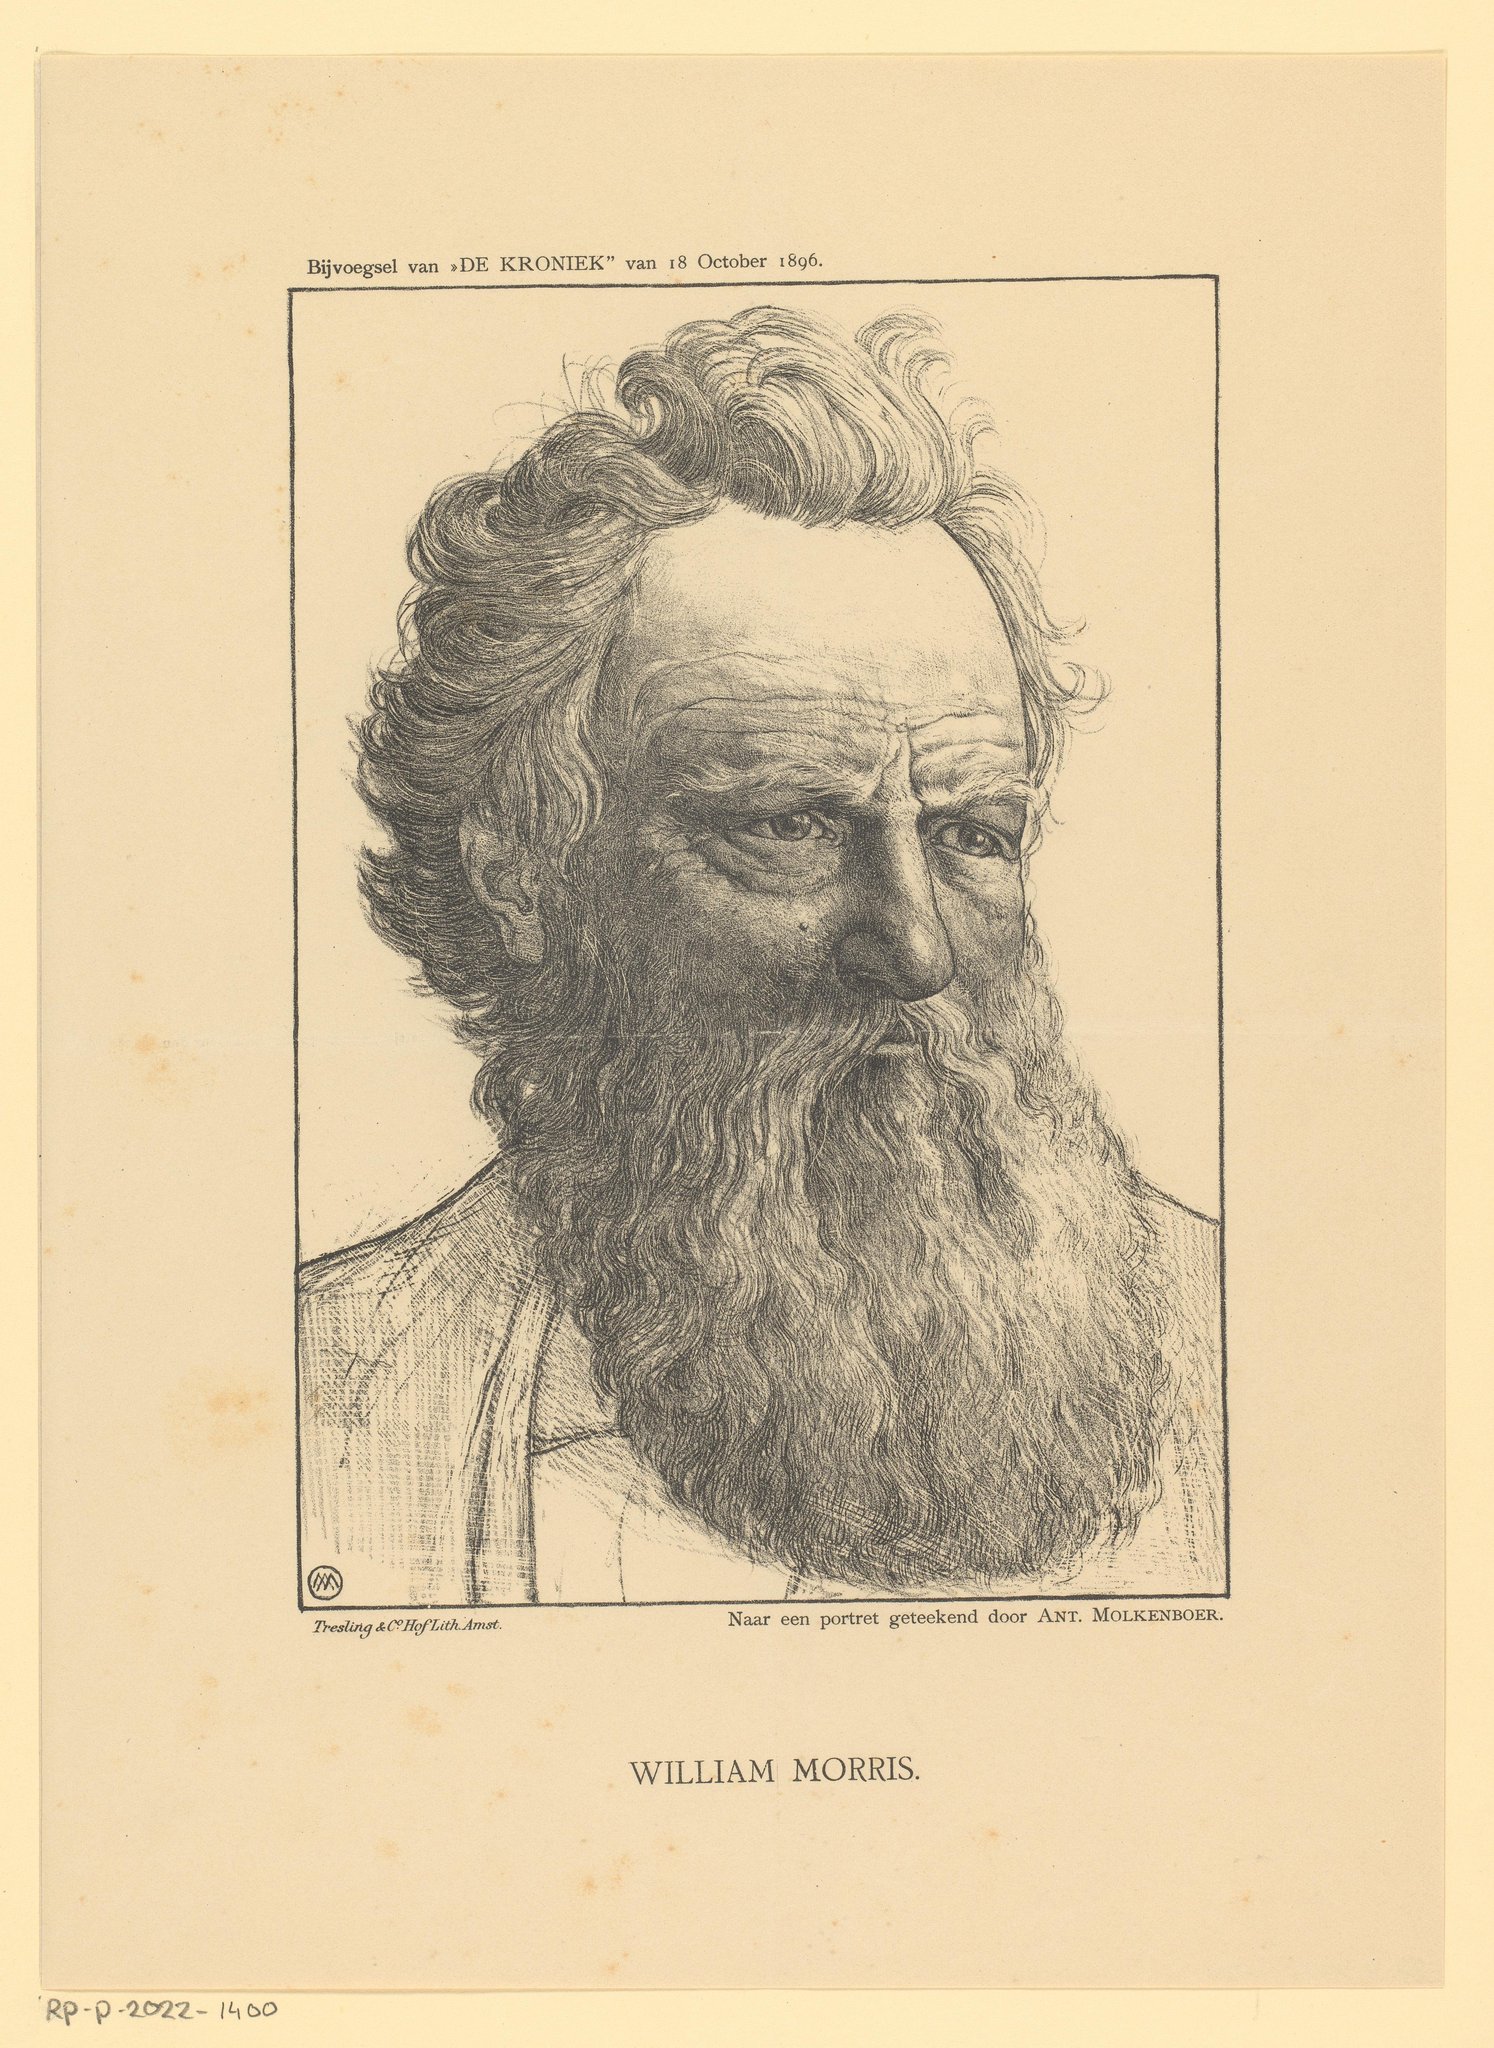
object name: print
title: Portret van William Morris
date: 1896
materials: paper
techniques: lithograph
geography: amsterdam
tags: painter, designer, william morris, historical persons, portrait, self-portrait of artist